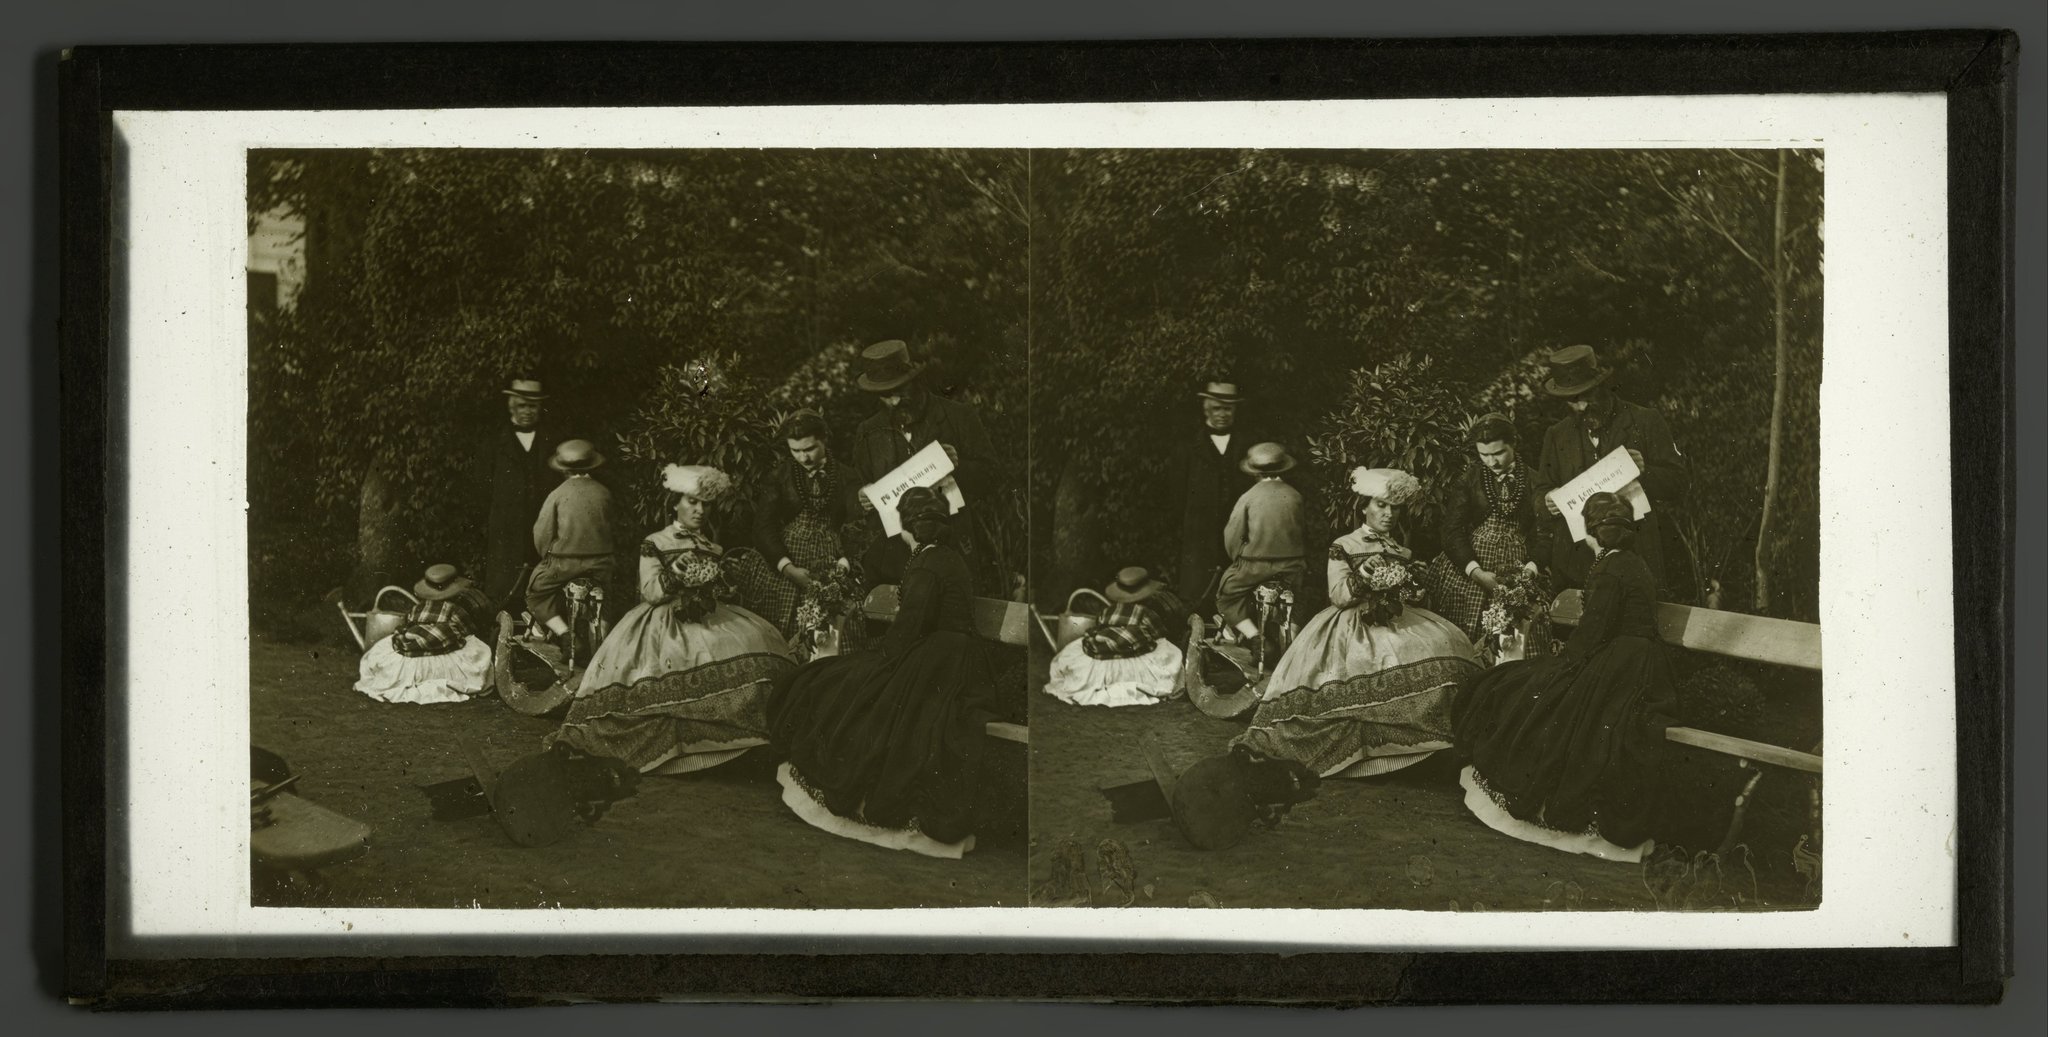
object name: stereoscopic photograph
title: Familie in het park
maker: Anonymous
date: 1890-1920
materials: glass, paper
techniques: slide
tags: park, family life